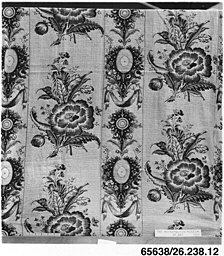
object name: floral print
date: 1788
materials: cotton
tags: flowers